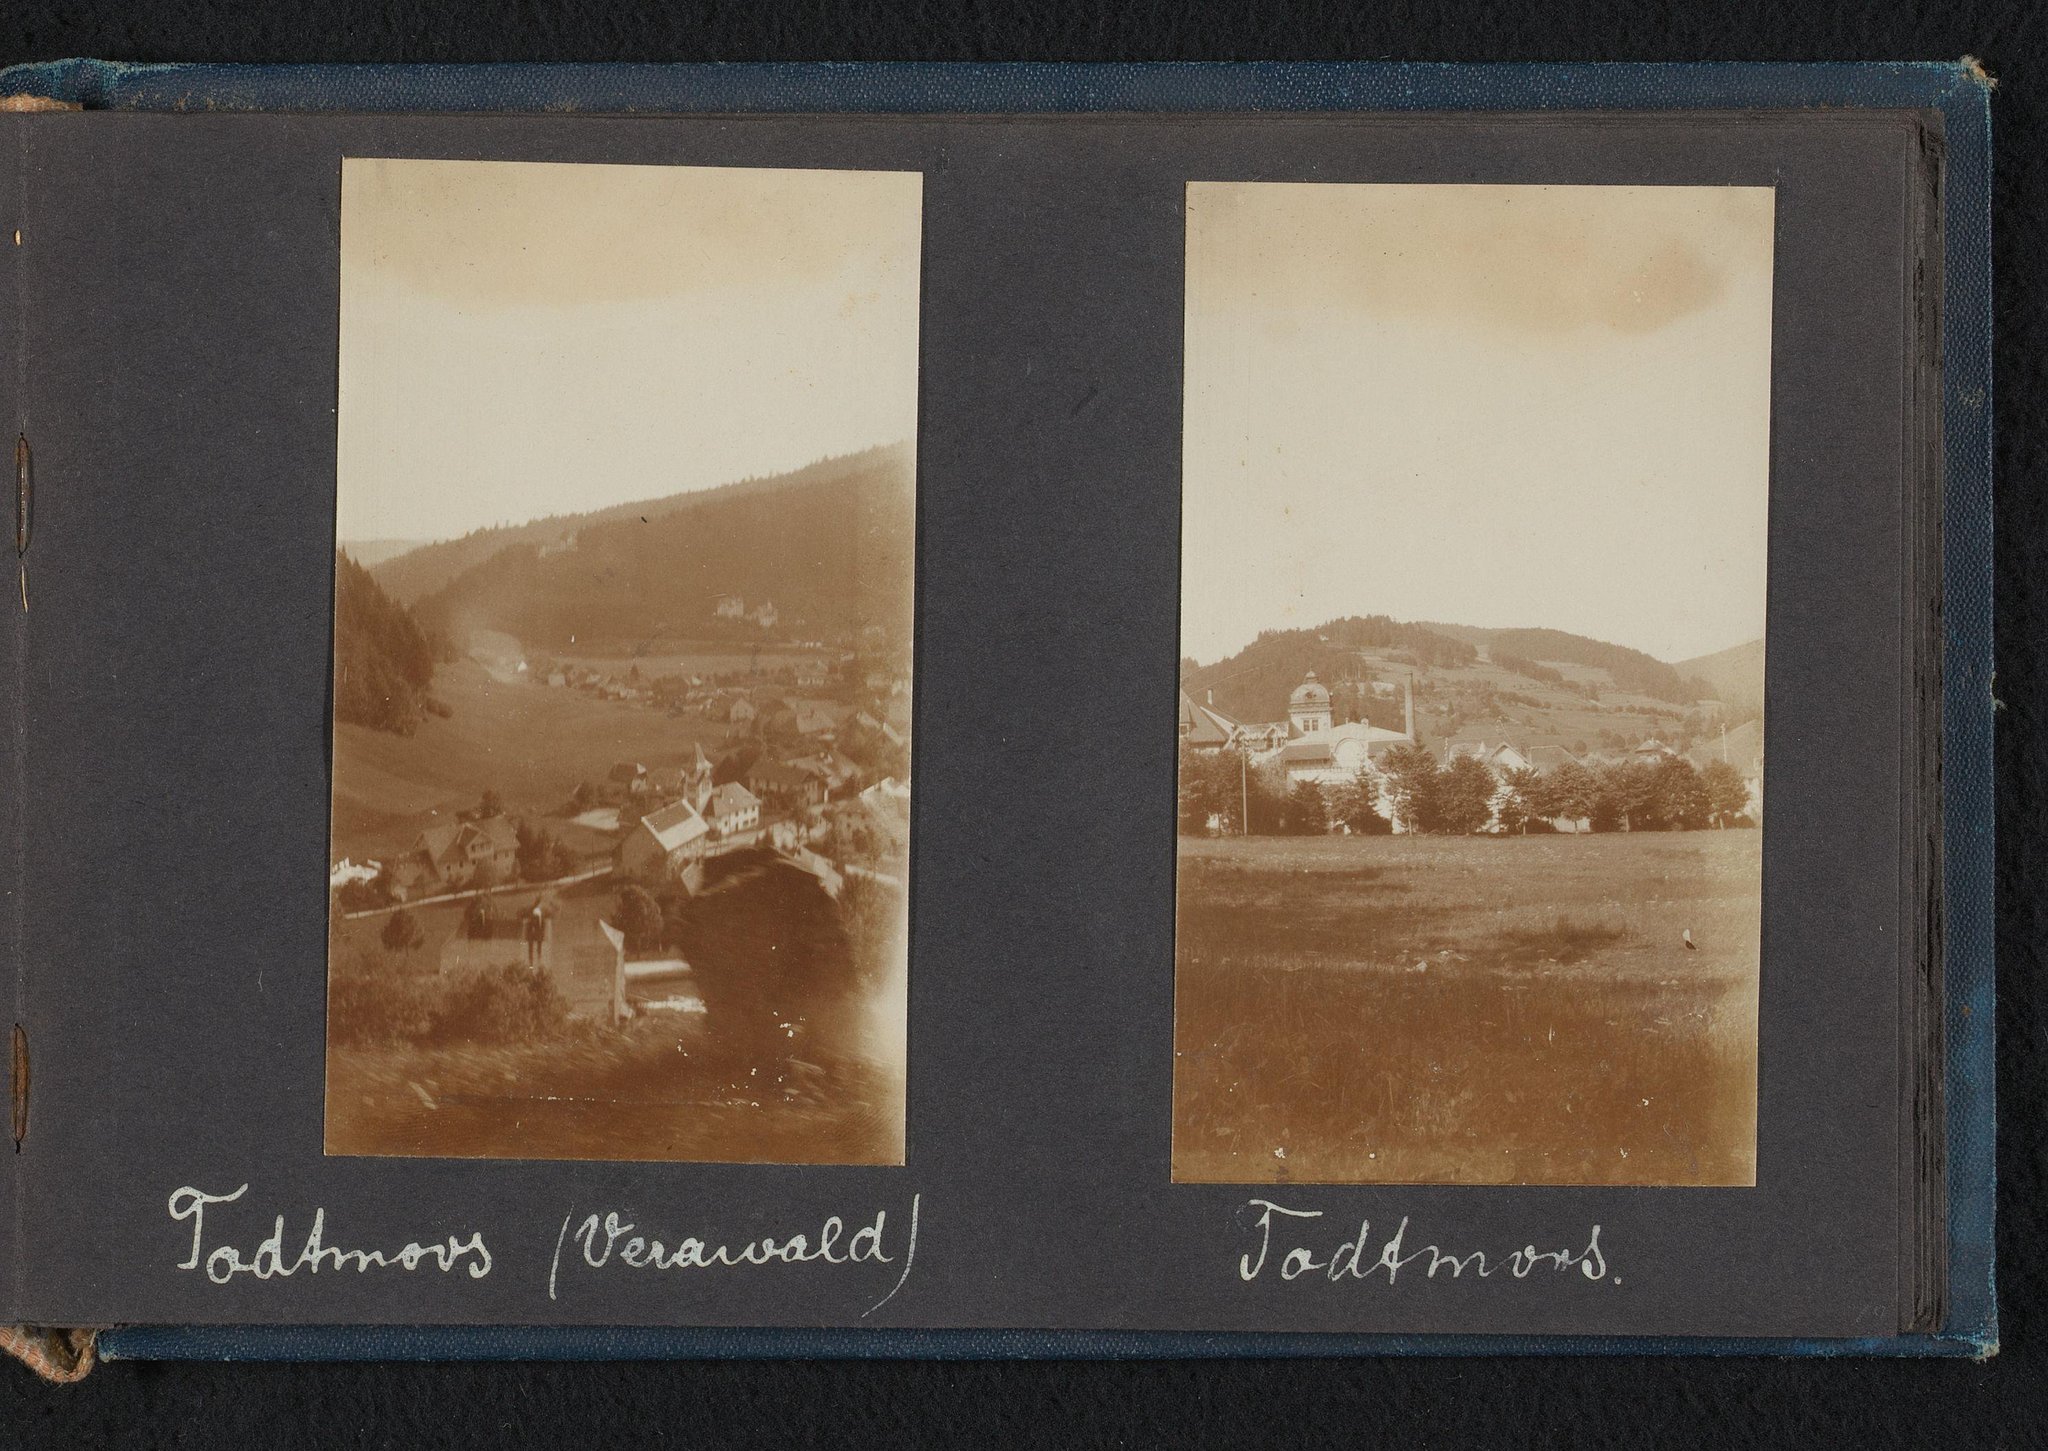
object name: photograph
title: Todtmoos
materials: paper, photographic support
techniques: gelatin silver print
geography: germany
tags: else wachenheimer-moos, low hill country, village, germany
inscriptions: inscription: ‘Todtmoos (Verawald) / Todtmoos’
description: Albumblad met twee foto's van landschap bij het plaatsje Todtmoos. Onderdeel van het fotoalbum van Else Wachenheimer-Moos en haar broers Arthur en Willy Moos en anderen in de periode 1913-1918.